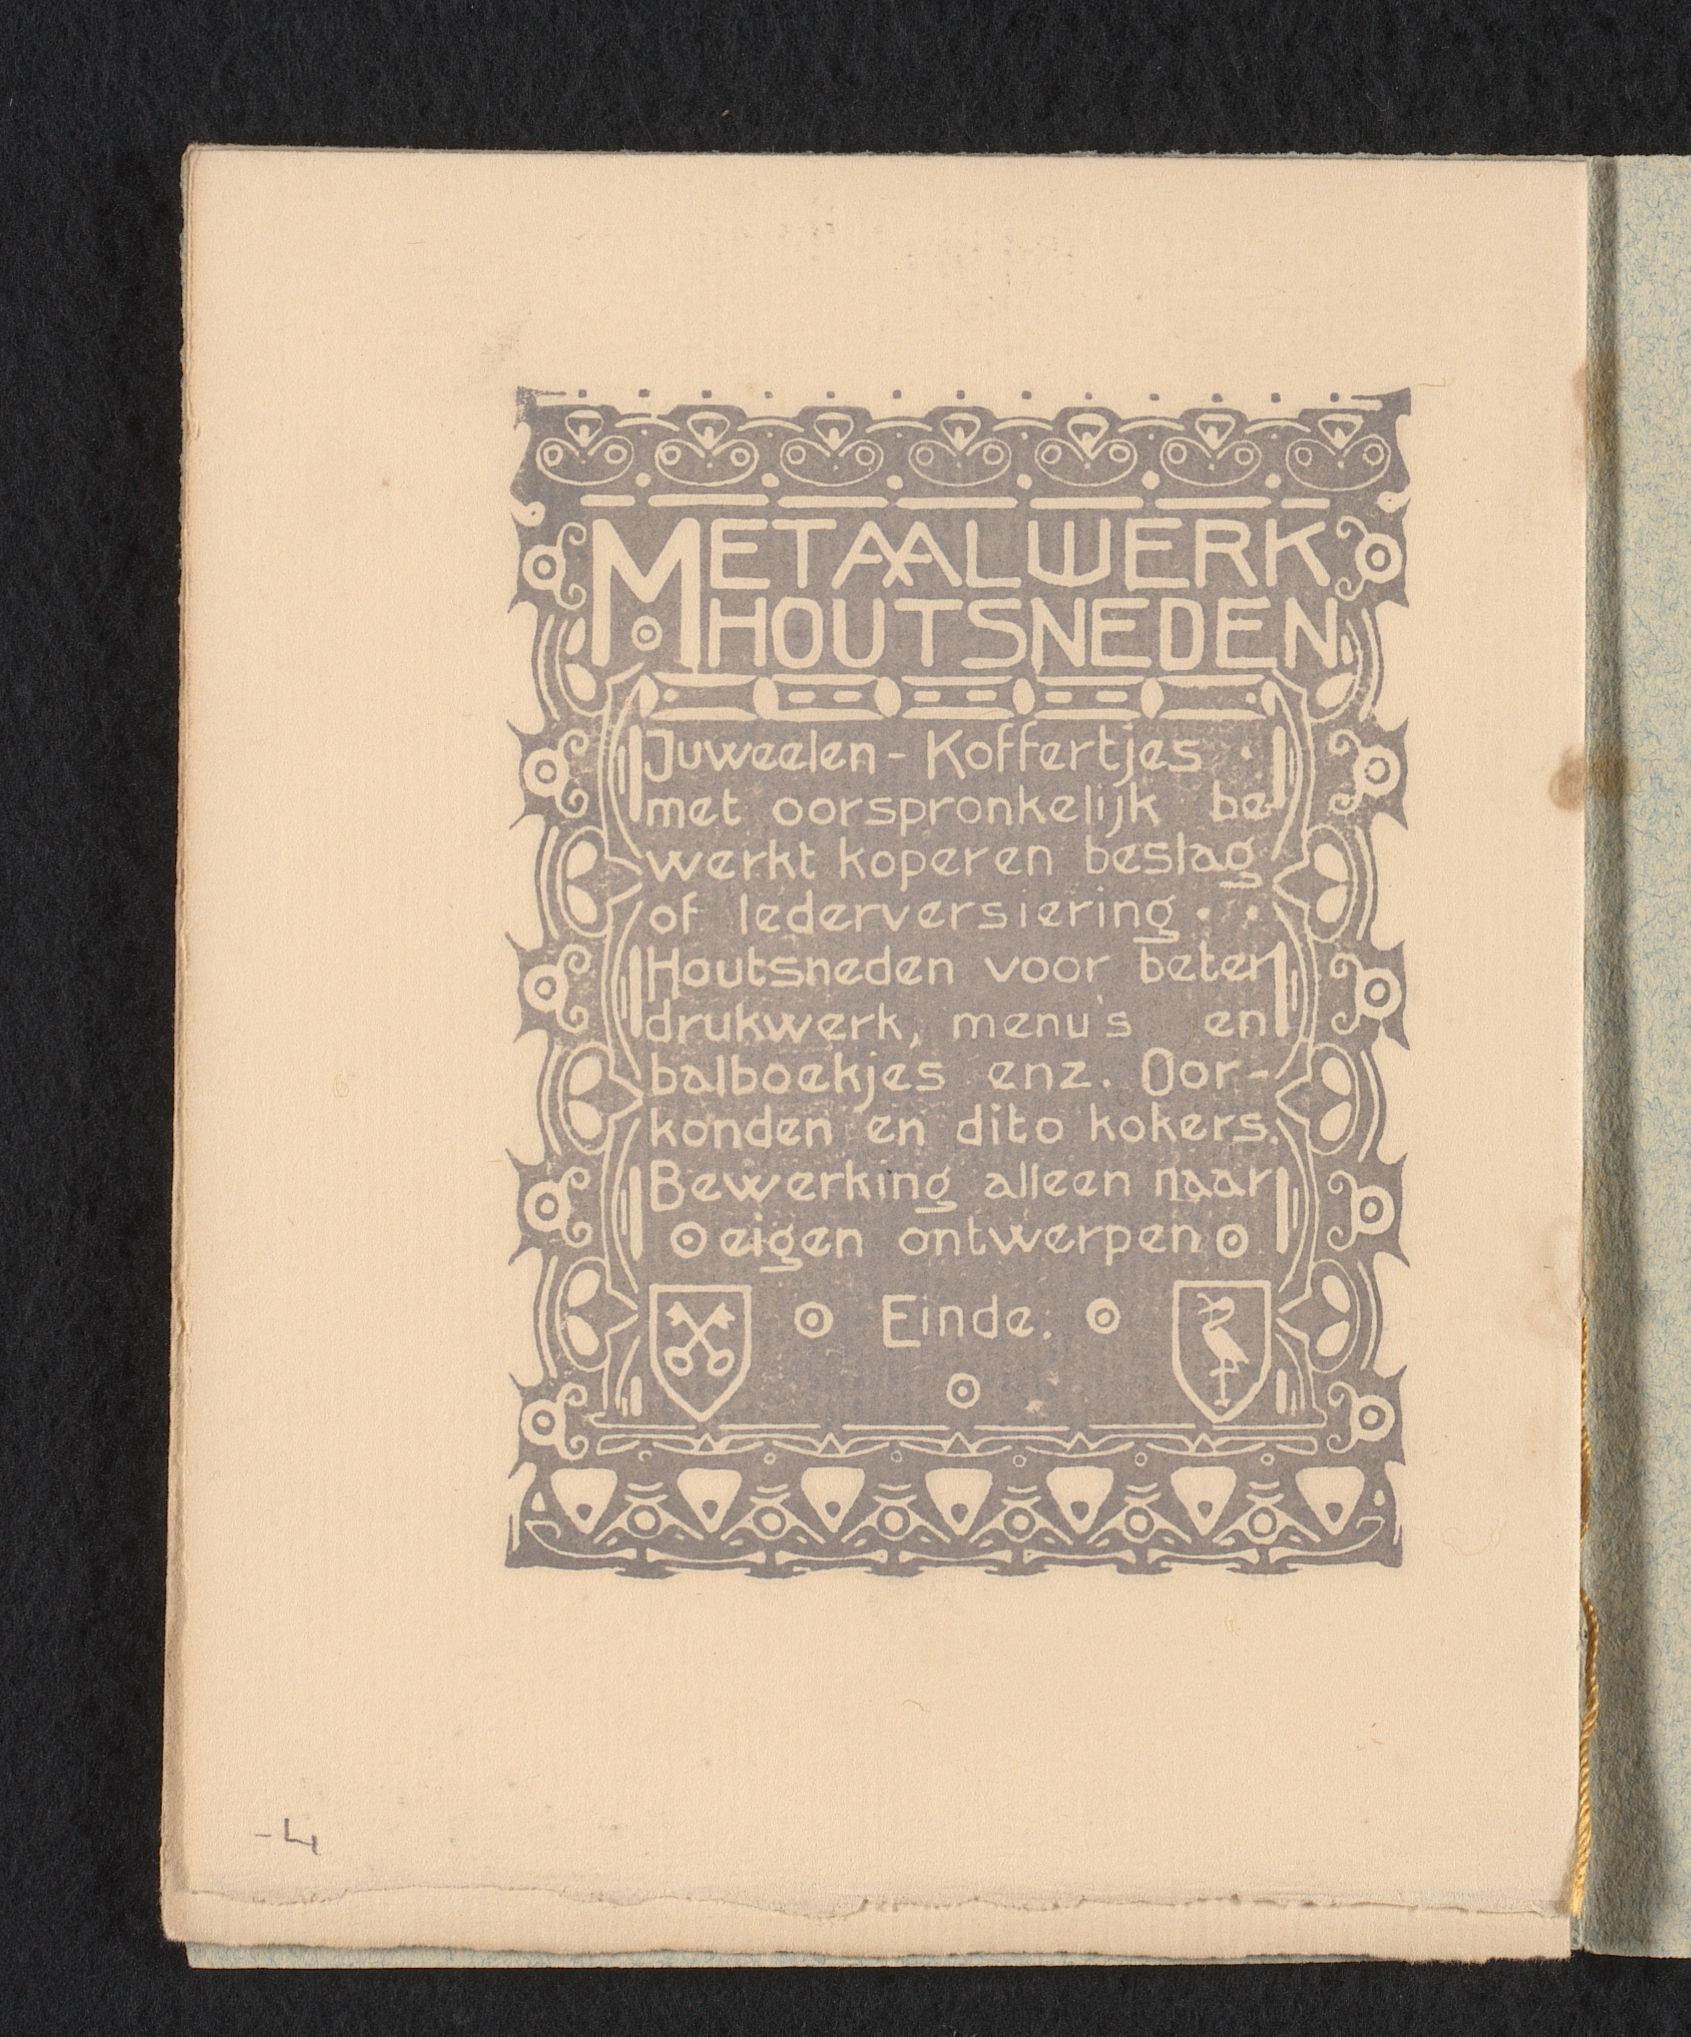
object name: print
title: Beschrijving van metaal- en houtsnijwerk van Loeber & Smits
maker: johannes bartholomeus smits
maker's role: designer, draughtsman, print maker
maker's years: 1874-1944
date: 1898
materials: paper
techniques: woodcut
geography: leiden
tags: ornaments ~ art, advertising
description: Beschrijving van de mogelijkheden voor metaal- en houtsnijwerk bij Loeber & Smits. Deze prent maakt deel uit van een album.